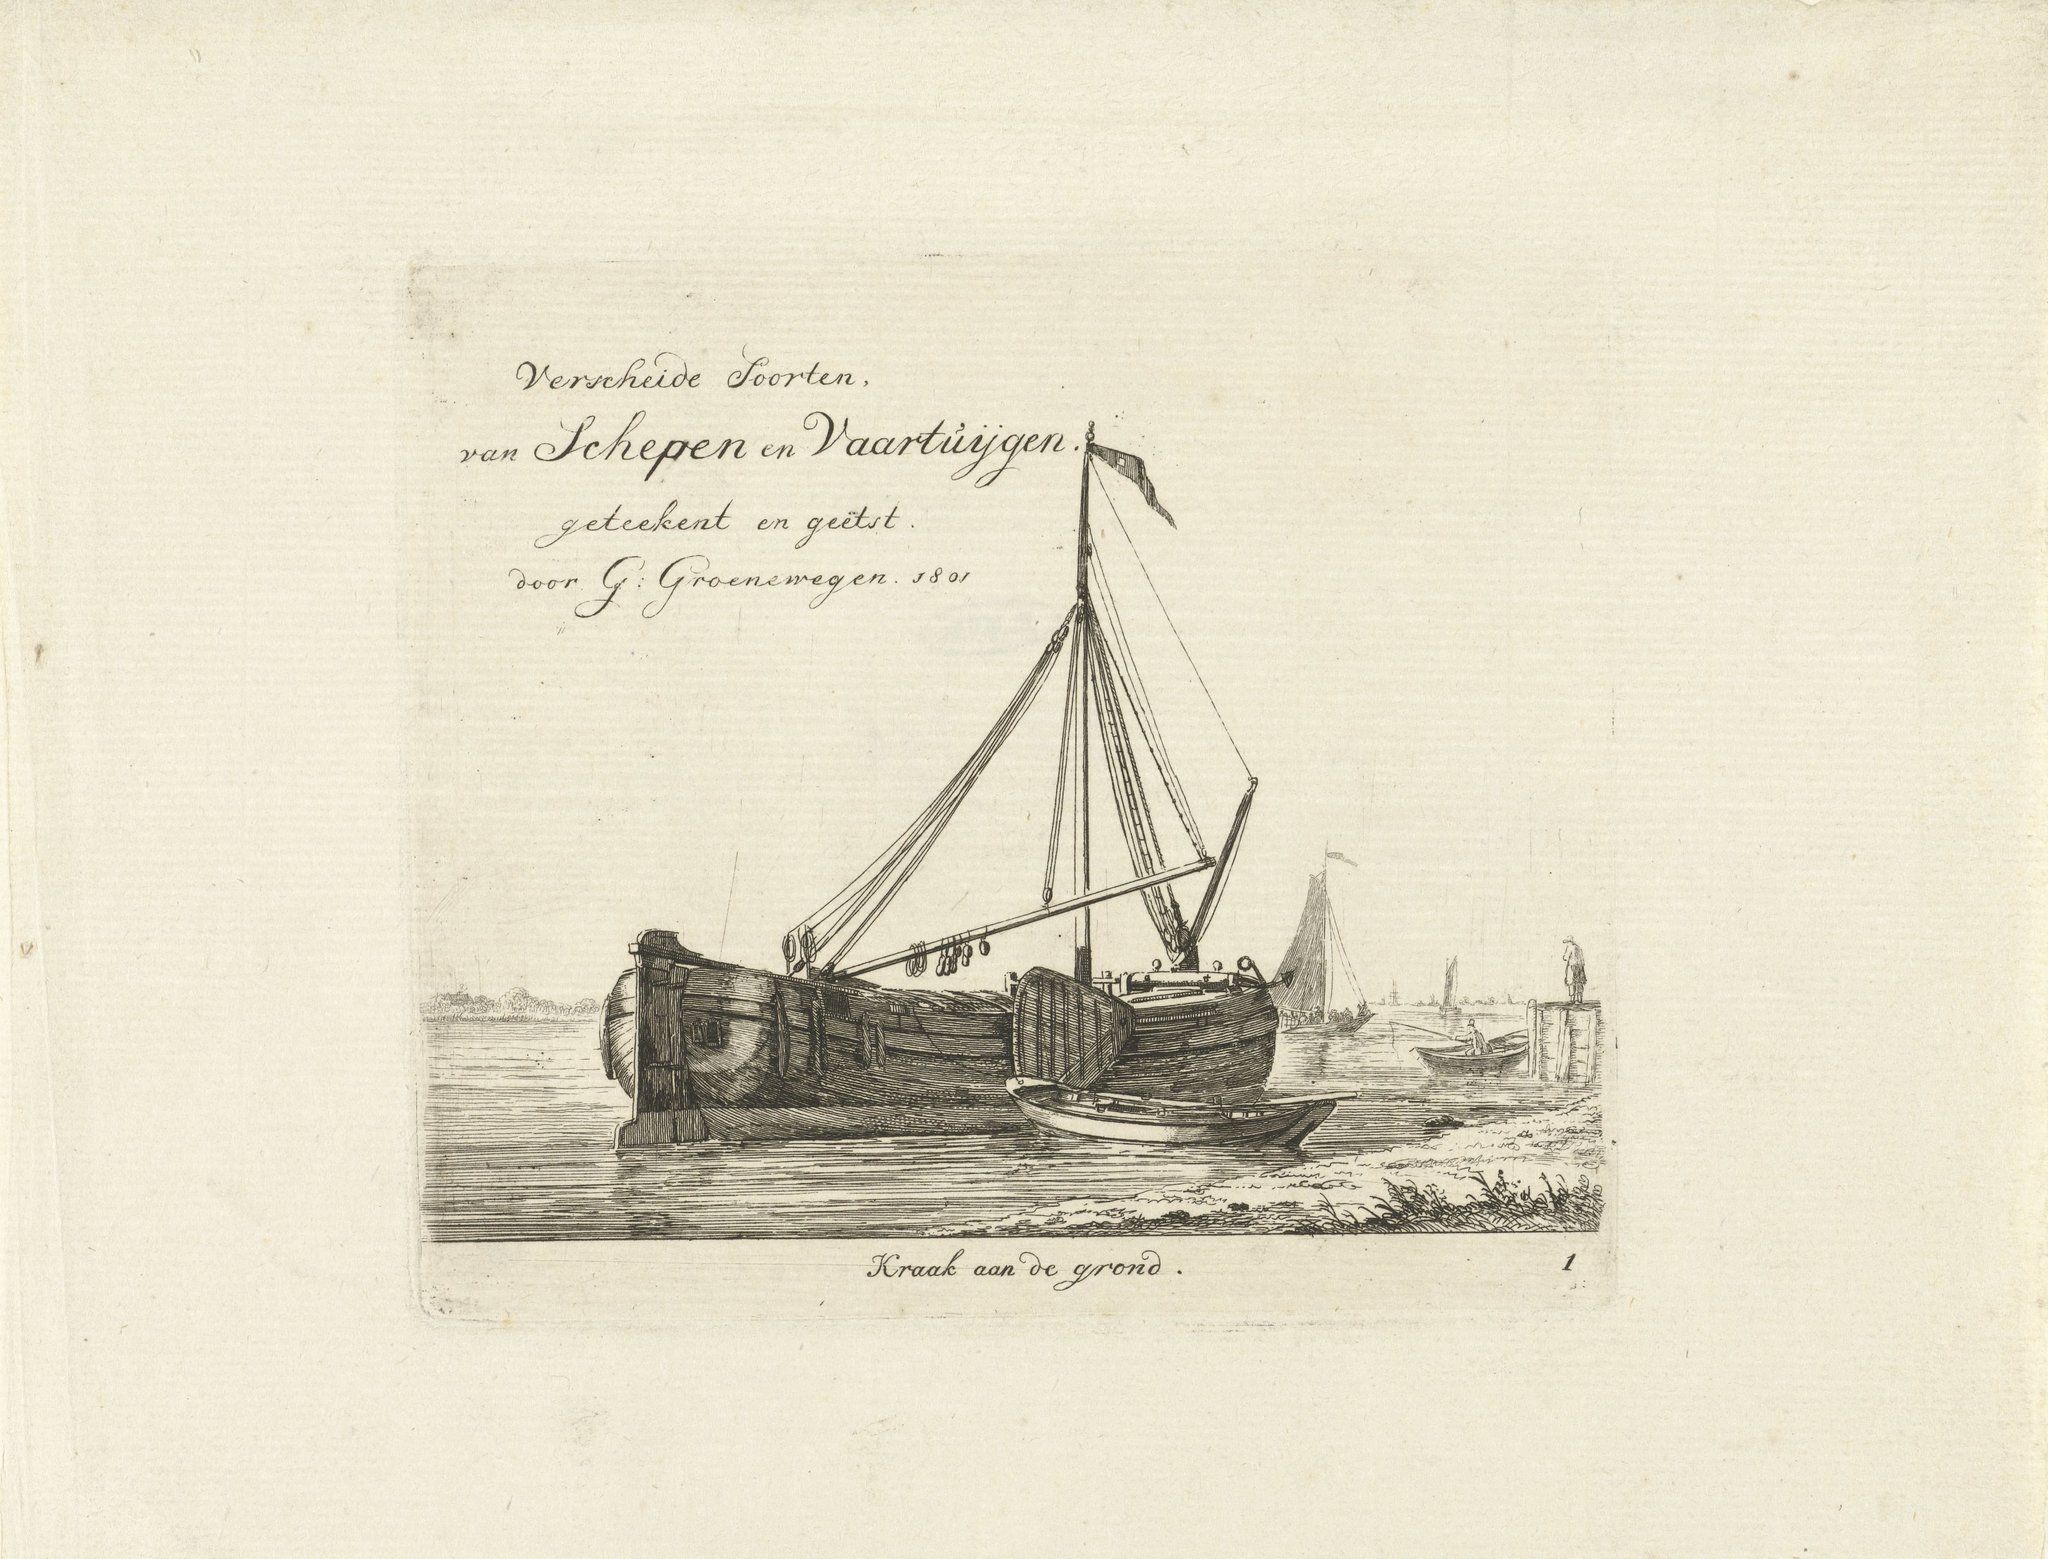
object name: print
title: Verschillende schepen serie [G]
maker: gerrit groenewegen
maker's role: draughtsman, print maker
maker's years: 1754-1826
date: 1801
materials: paper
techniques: etching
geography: rotterdam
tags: ships (in general)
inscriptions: collector's mark: Lugt 2228, collector's mark: Lugt 2760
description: Een aan de grond gelopen Kraak met daarnaast een sloep. Op de achtergrond zijn contouren van een vissersboot en verschillende zeilschepen te zien. De prent is een titelprent van een serie prenten met verschillende schepen en vaartuigen. In de marge: Kraak aan de grond. 1.